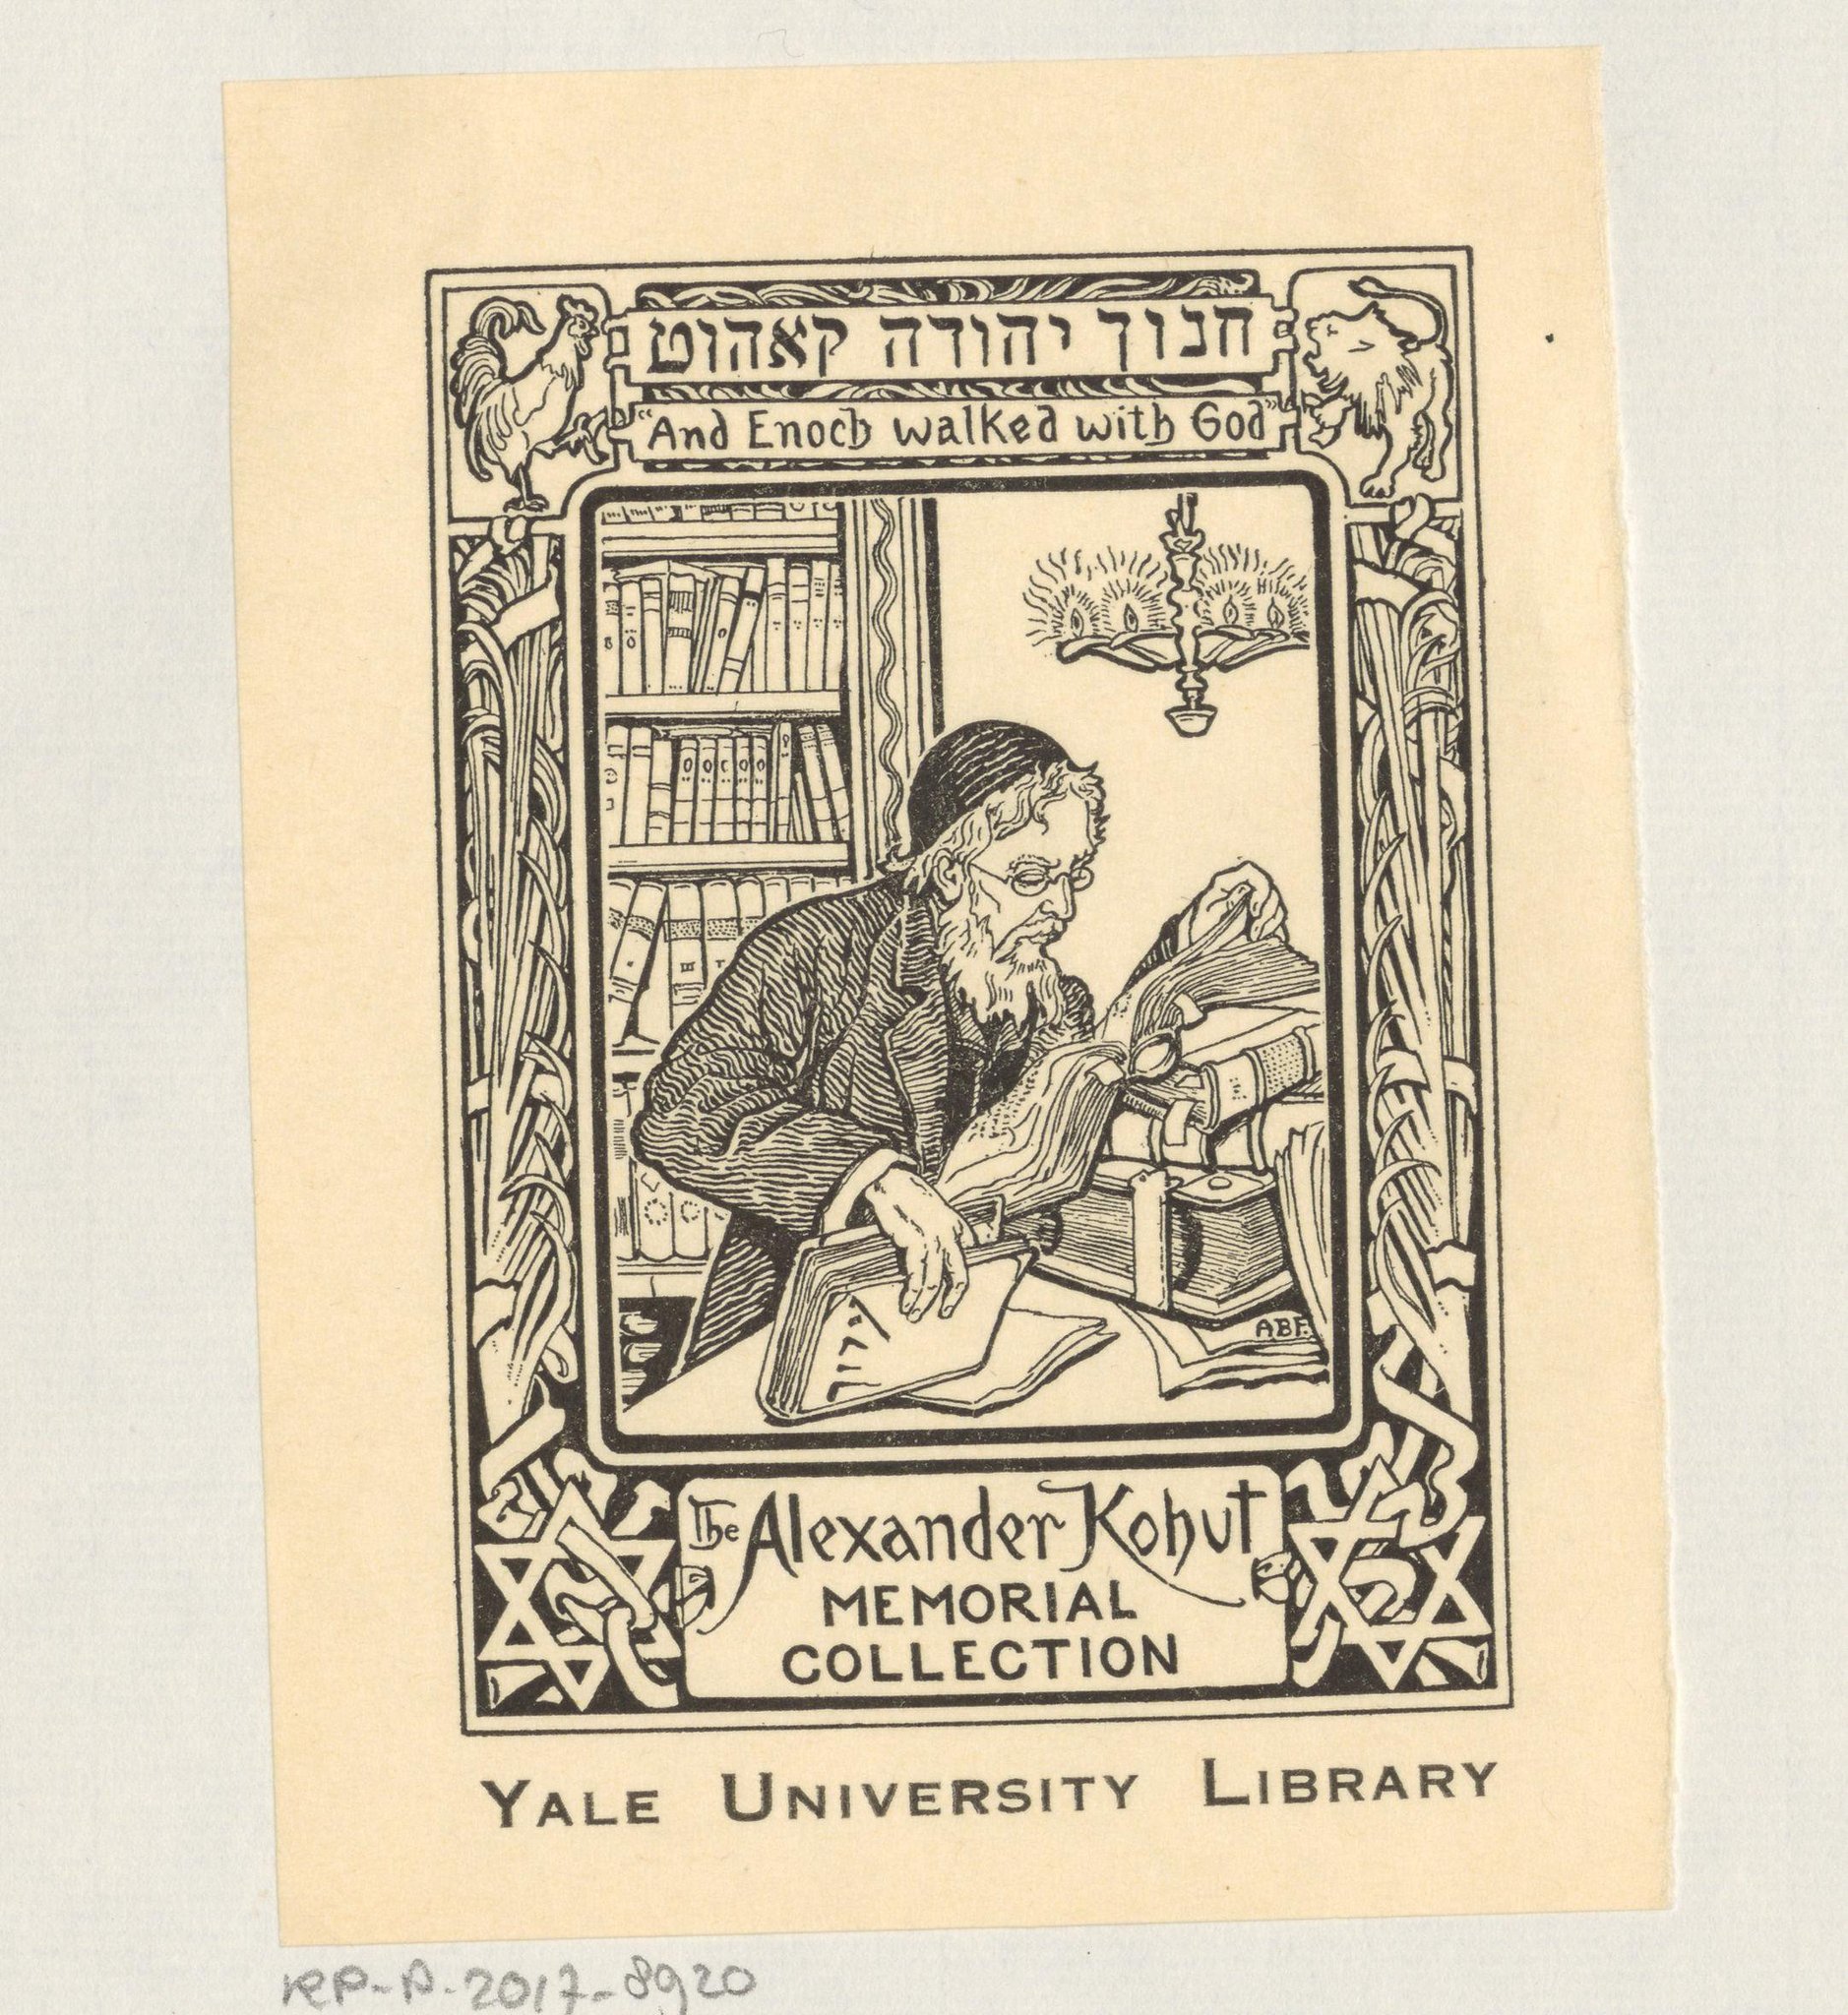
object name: bookplate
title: Ex libris van de Yale University Library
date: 1894-1939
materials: paper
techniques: printing block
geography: north and central america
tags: bookshelves, reading, rabbi